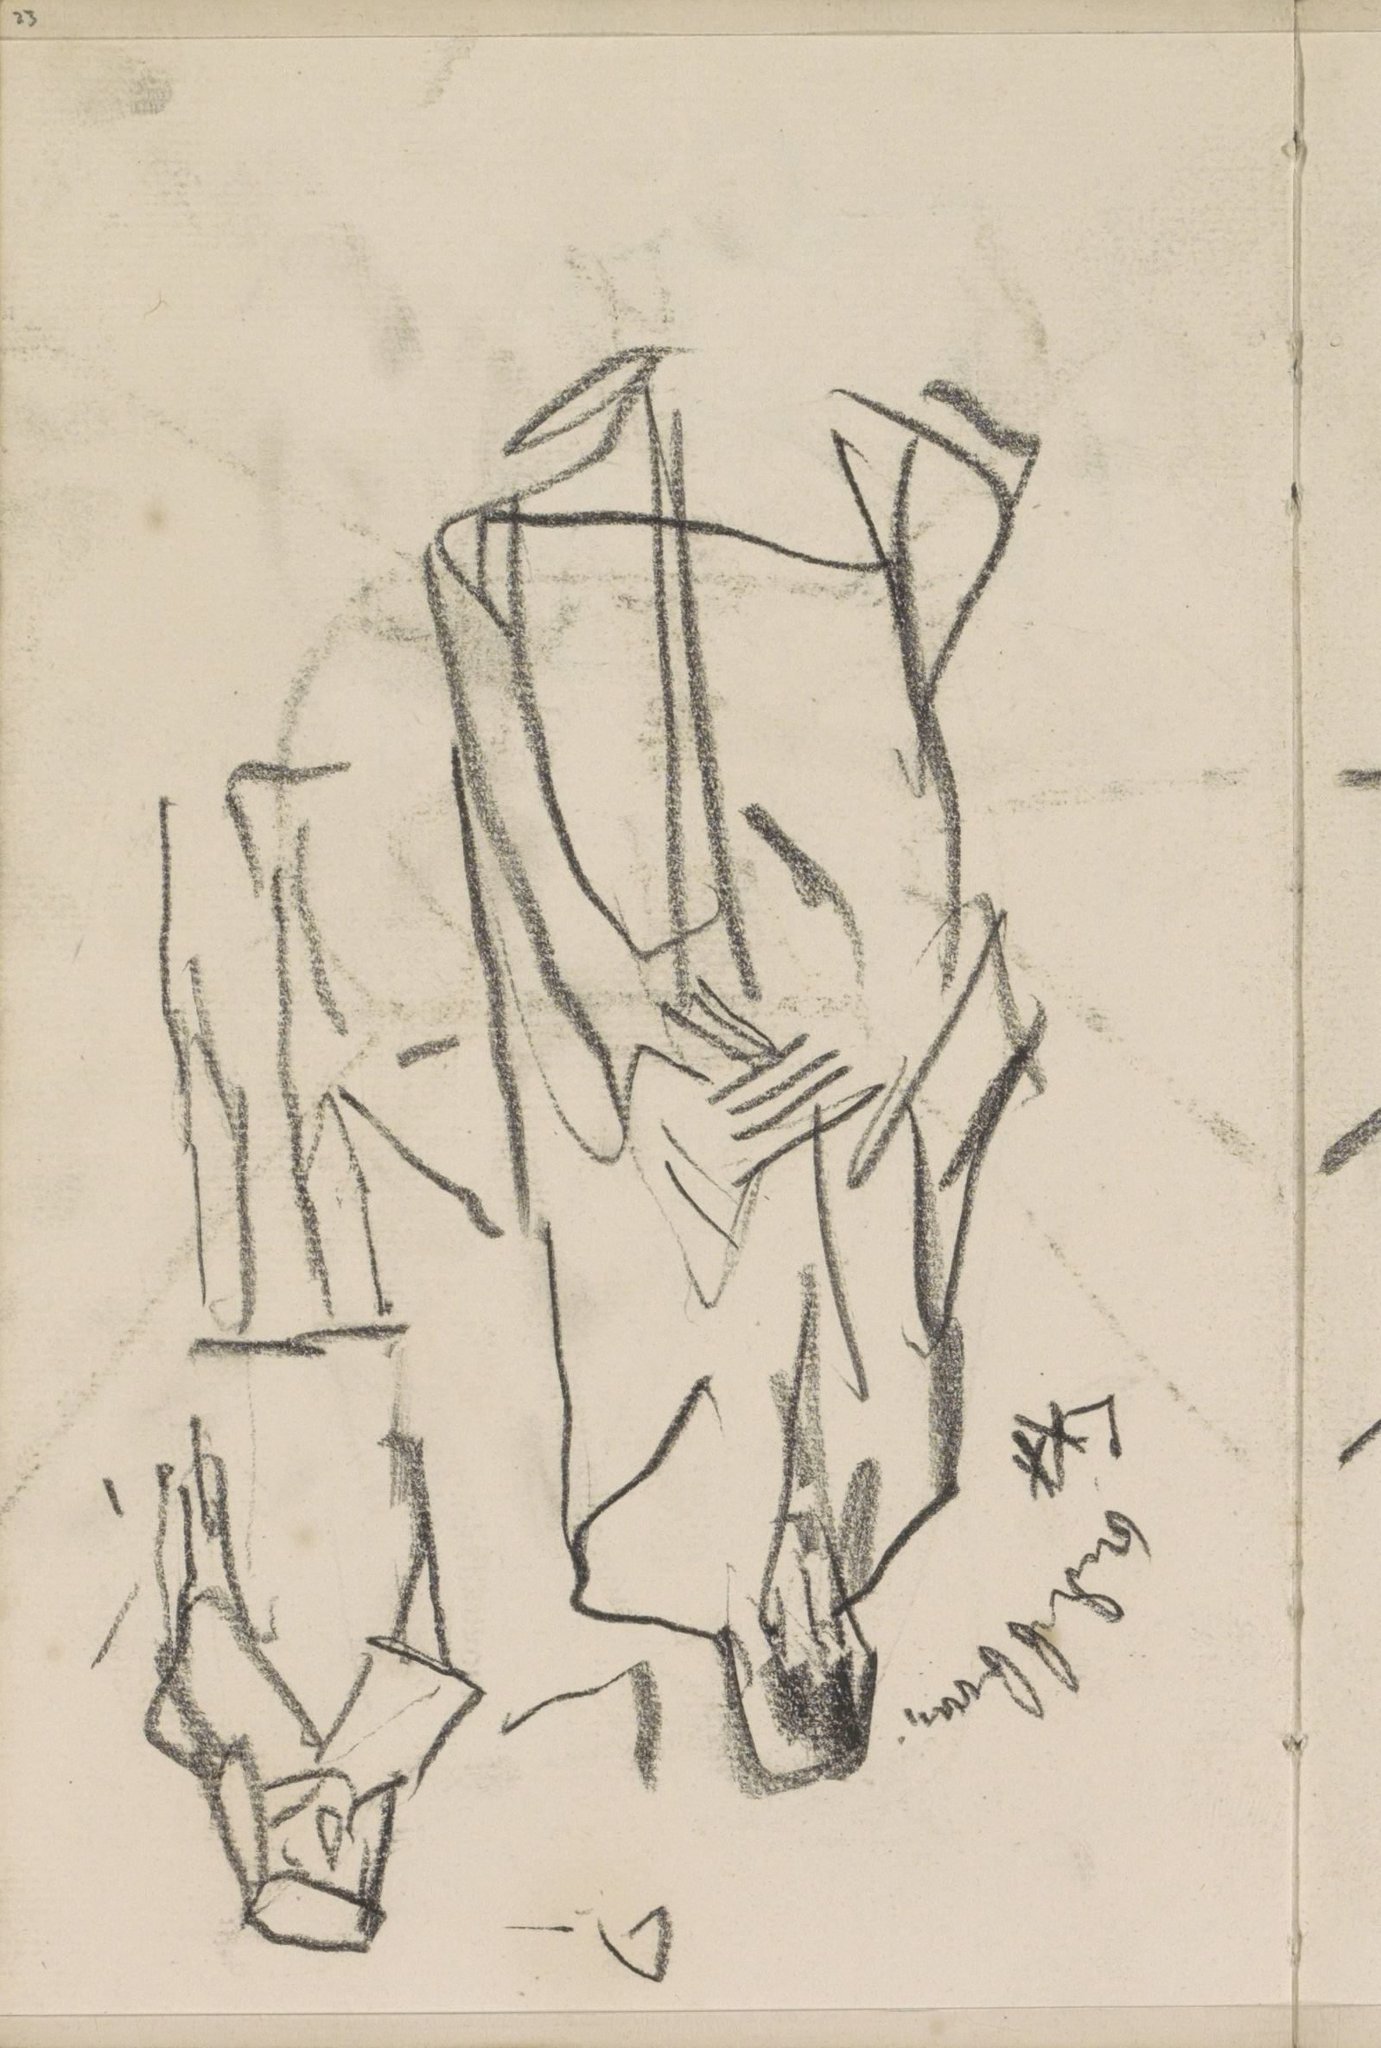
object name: sketchbook leaf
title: Twee staande figuren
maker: george hendrik breitner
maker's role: draughtsman, painter, print maker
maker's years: 1857-1923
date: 1883-1885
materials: chalk, paper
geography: the hague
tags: old woman (+ standing), youth, adolescent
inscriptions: annotation: ‘onder de boom.[?]’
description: Vooraan mogelijk een oude vrouw die op een stok leunt. Pagina 23 uit een schetsboek met 18 bladen.